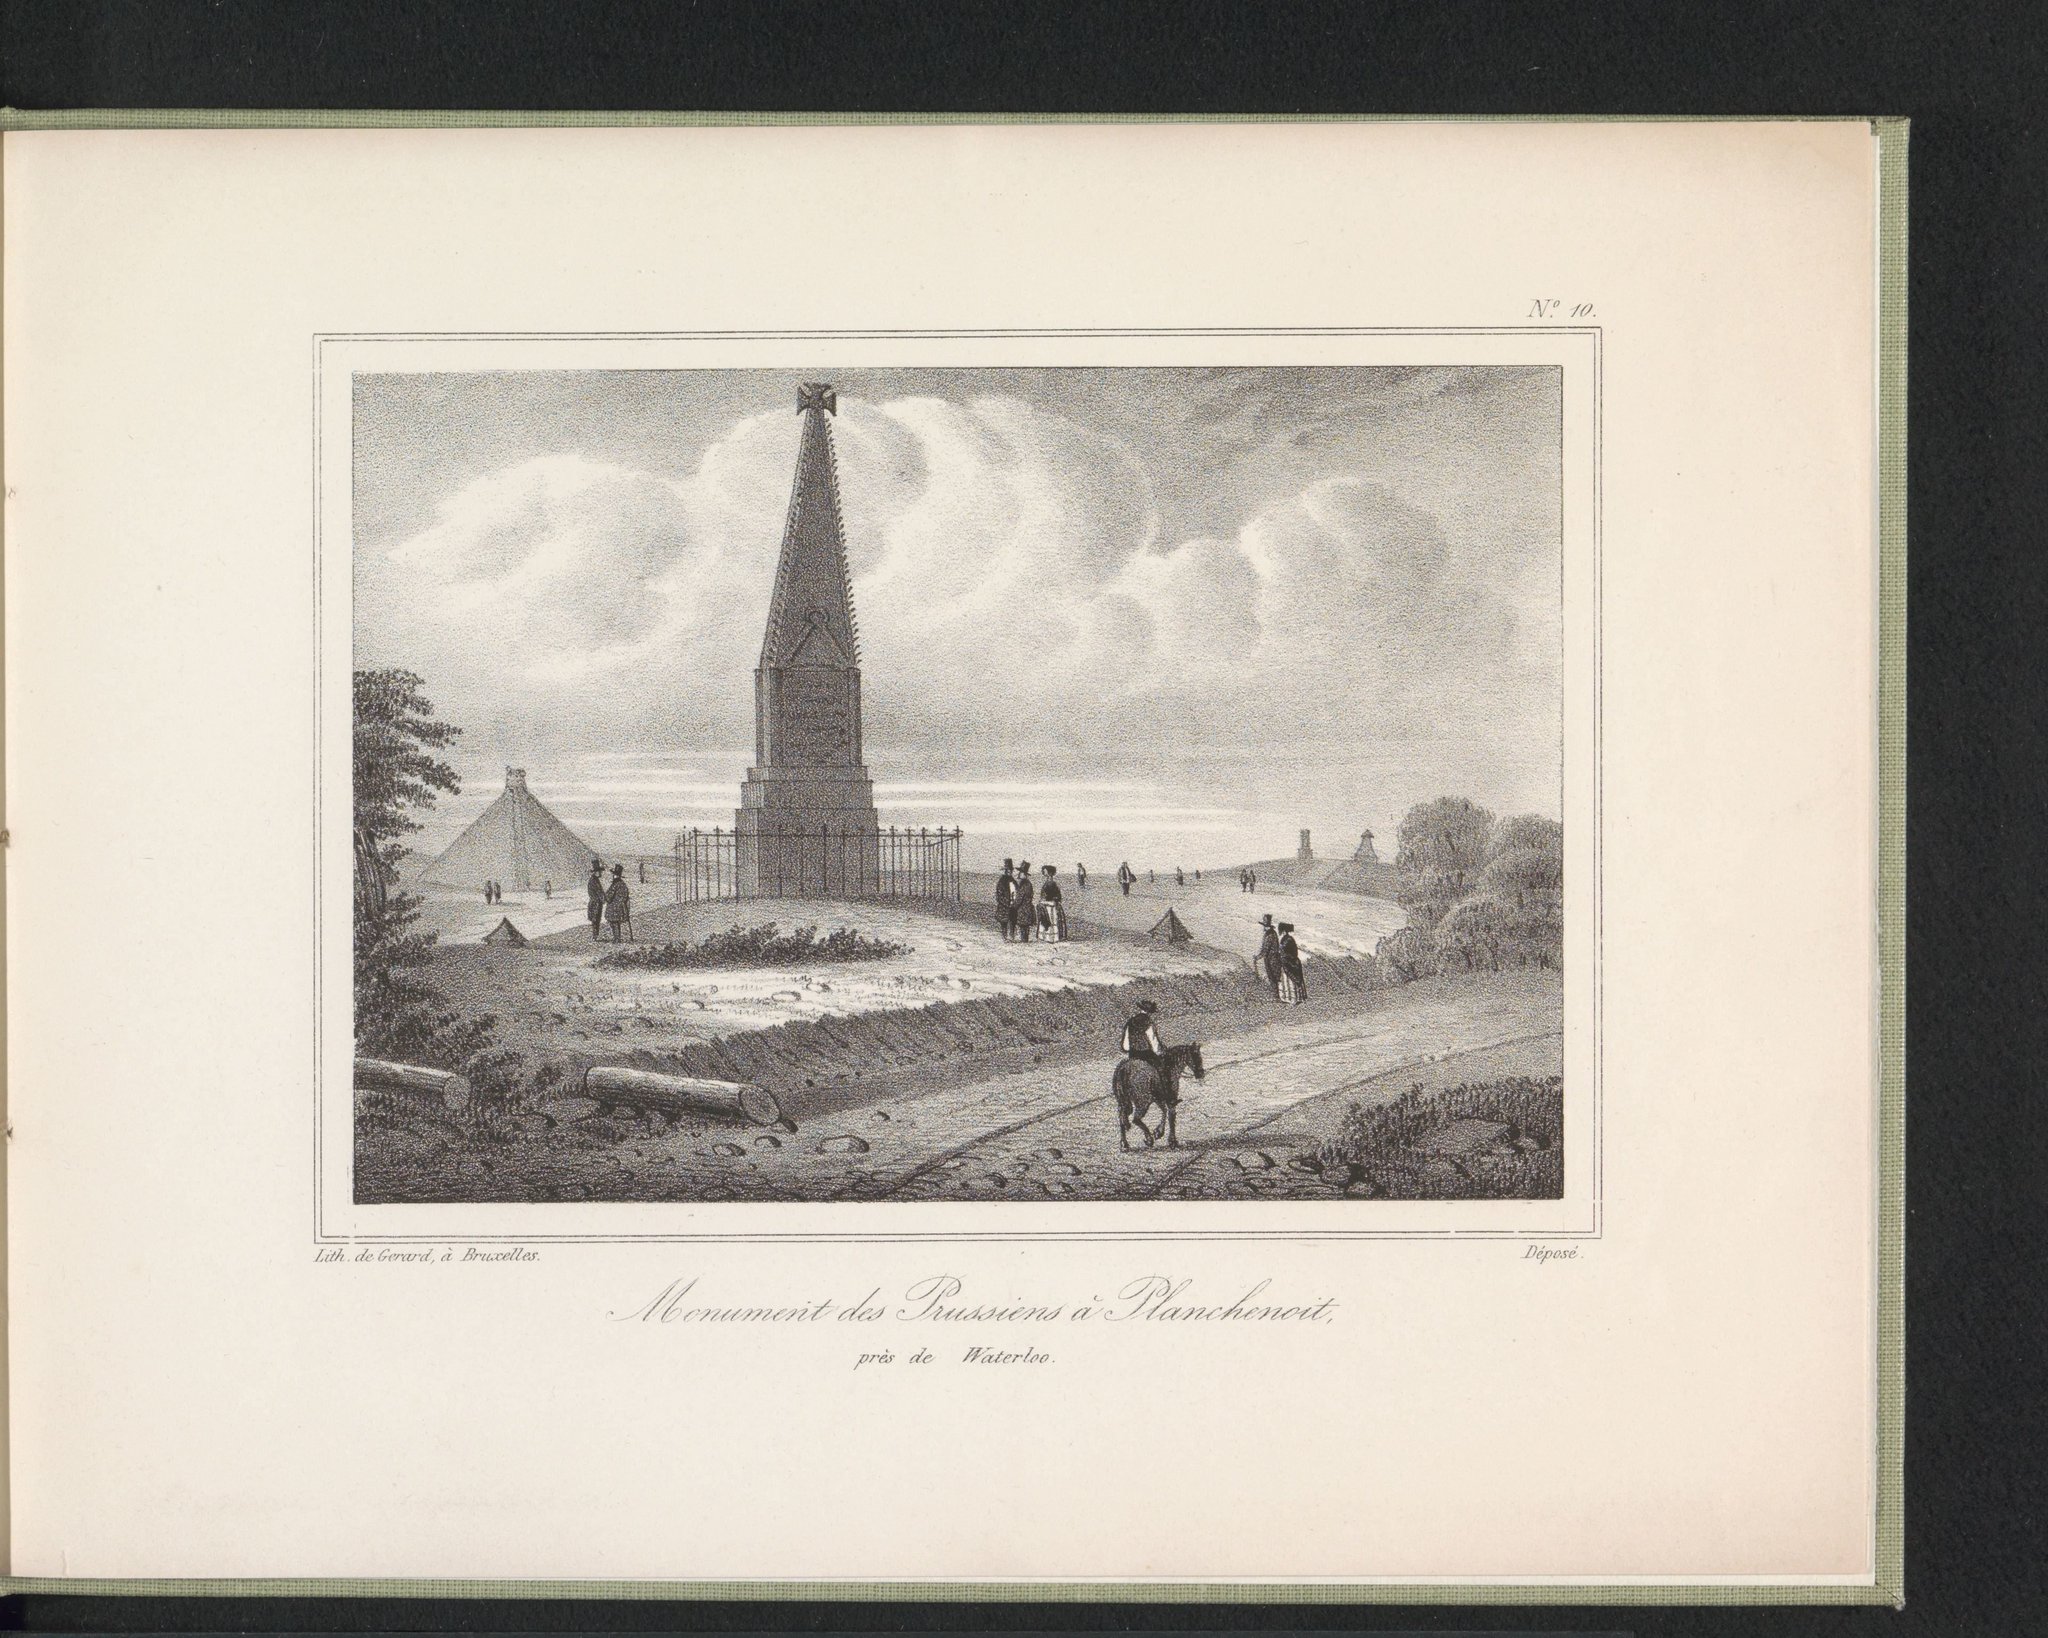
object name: print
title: Monument voor de Pruisen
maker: h. gérard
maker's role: printer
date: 1842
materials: paper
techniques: lithograph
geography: brussels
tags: landscape with monument, waterloo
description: Het monument voor de gevallen Pruisische militairen, te Plancenoit nabij Waterloo. Links op de grond twee boomstammen. Onderdeel van een album met twaalf platen met gezichten uit ca. 1840-1846 van de omgeving waar de slag bij Waterloo plaatsvond op 18 juni 1815. Genummerd rechtsboven: No. 10.